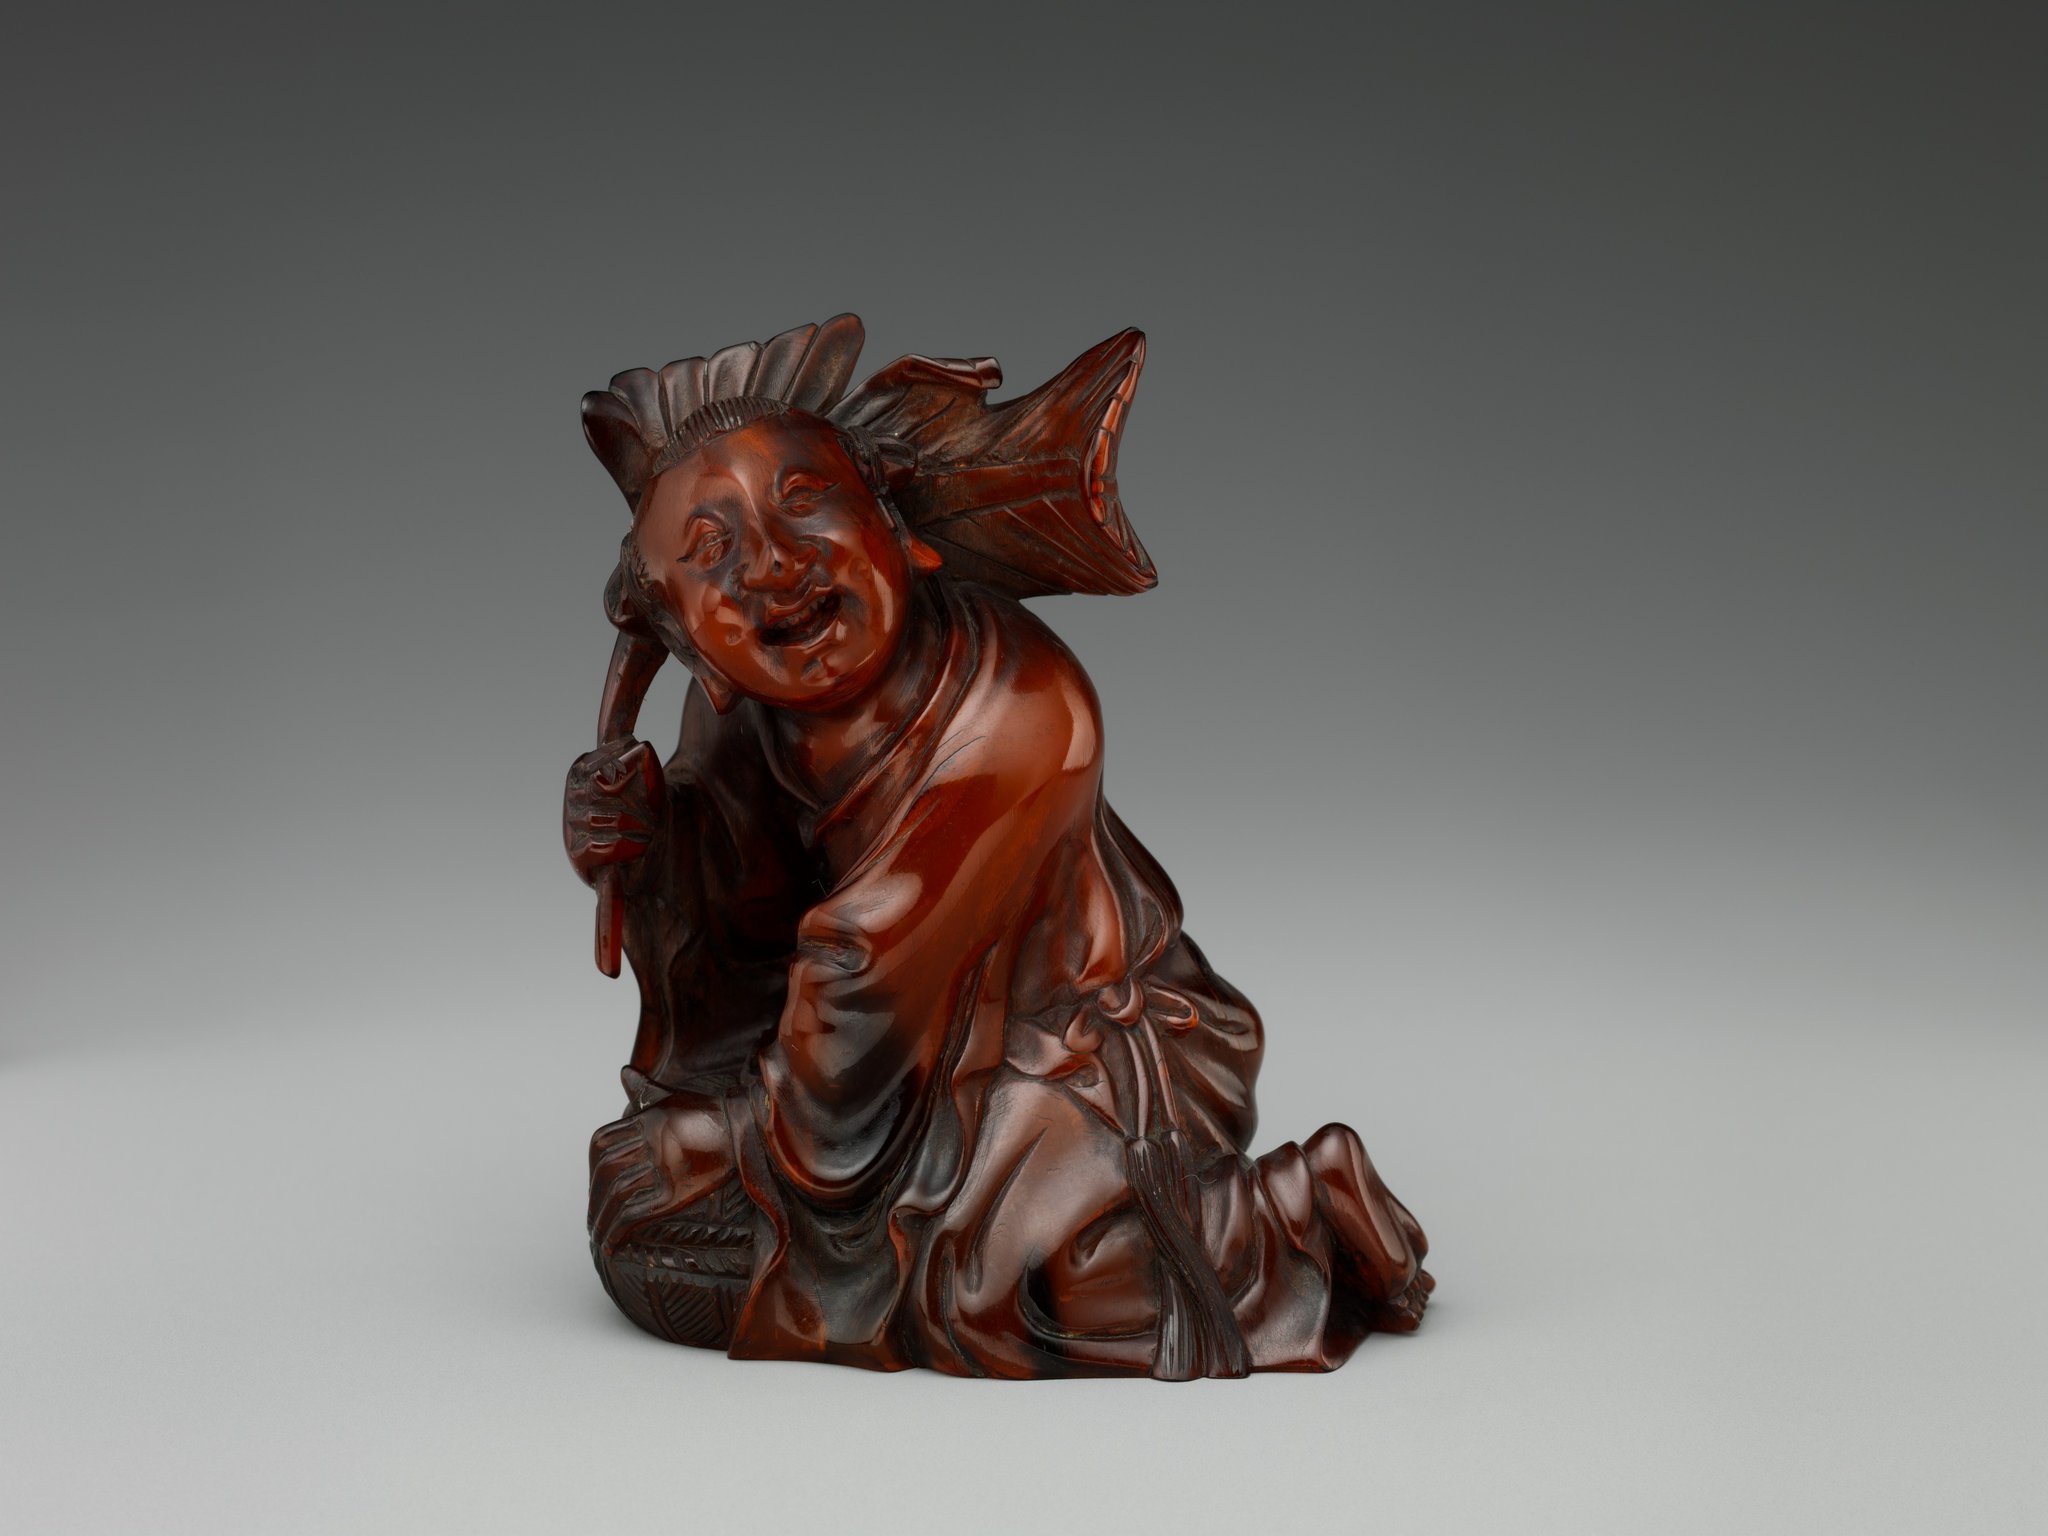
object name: figure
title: Boy with leaves and box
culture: chinese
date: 1801-1900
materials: horn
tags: boys